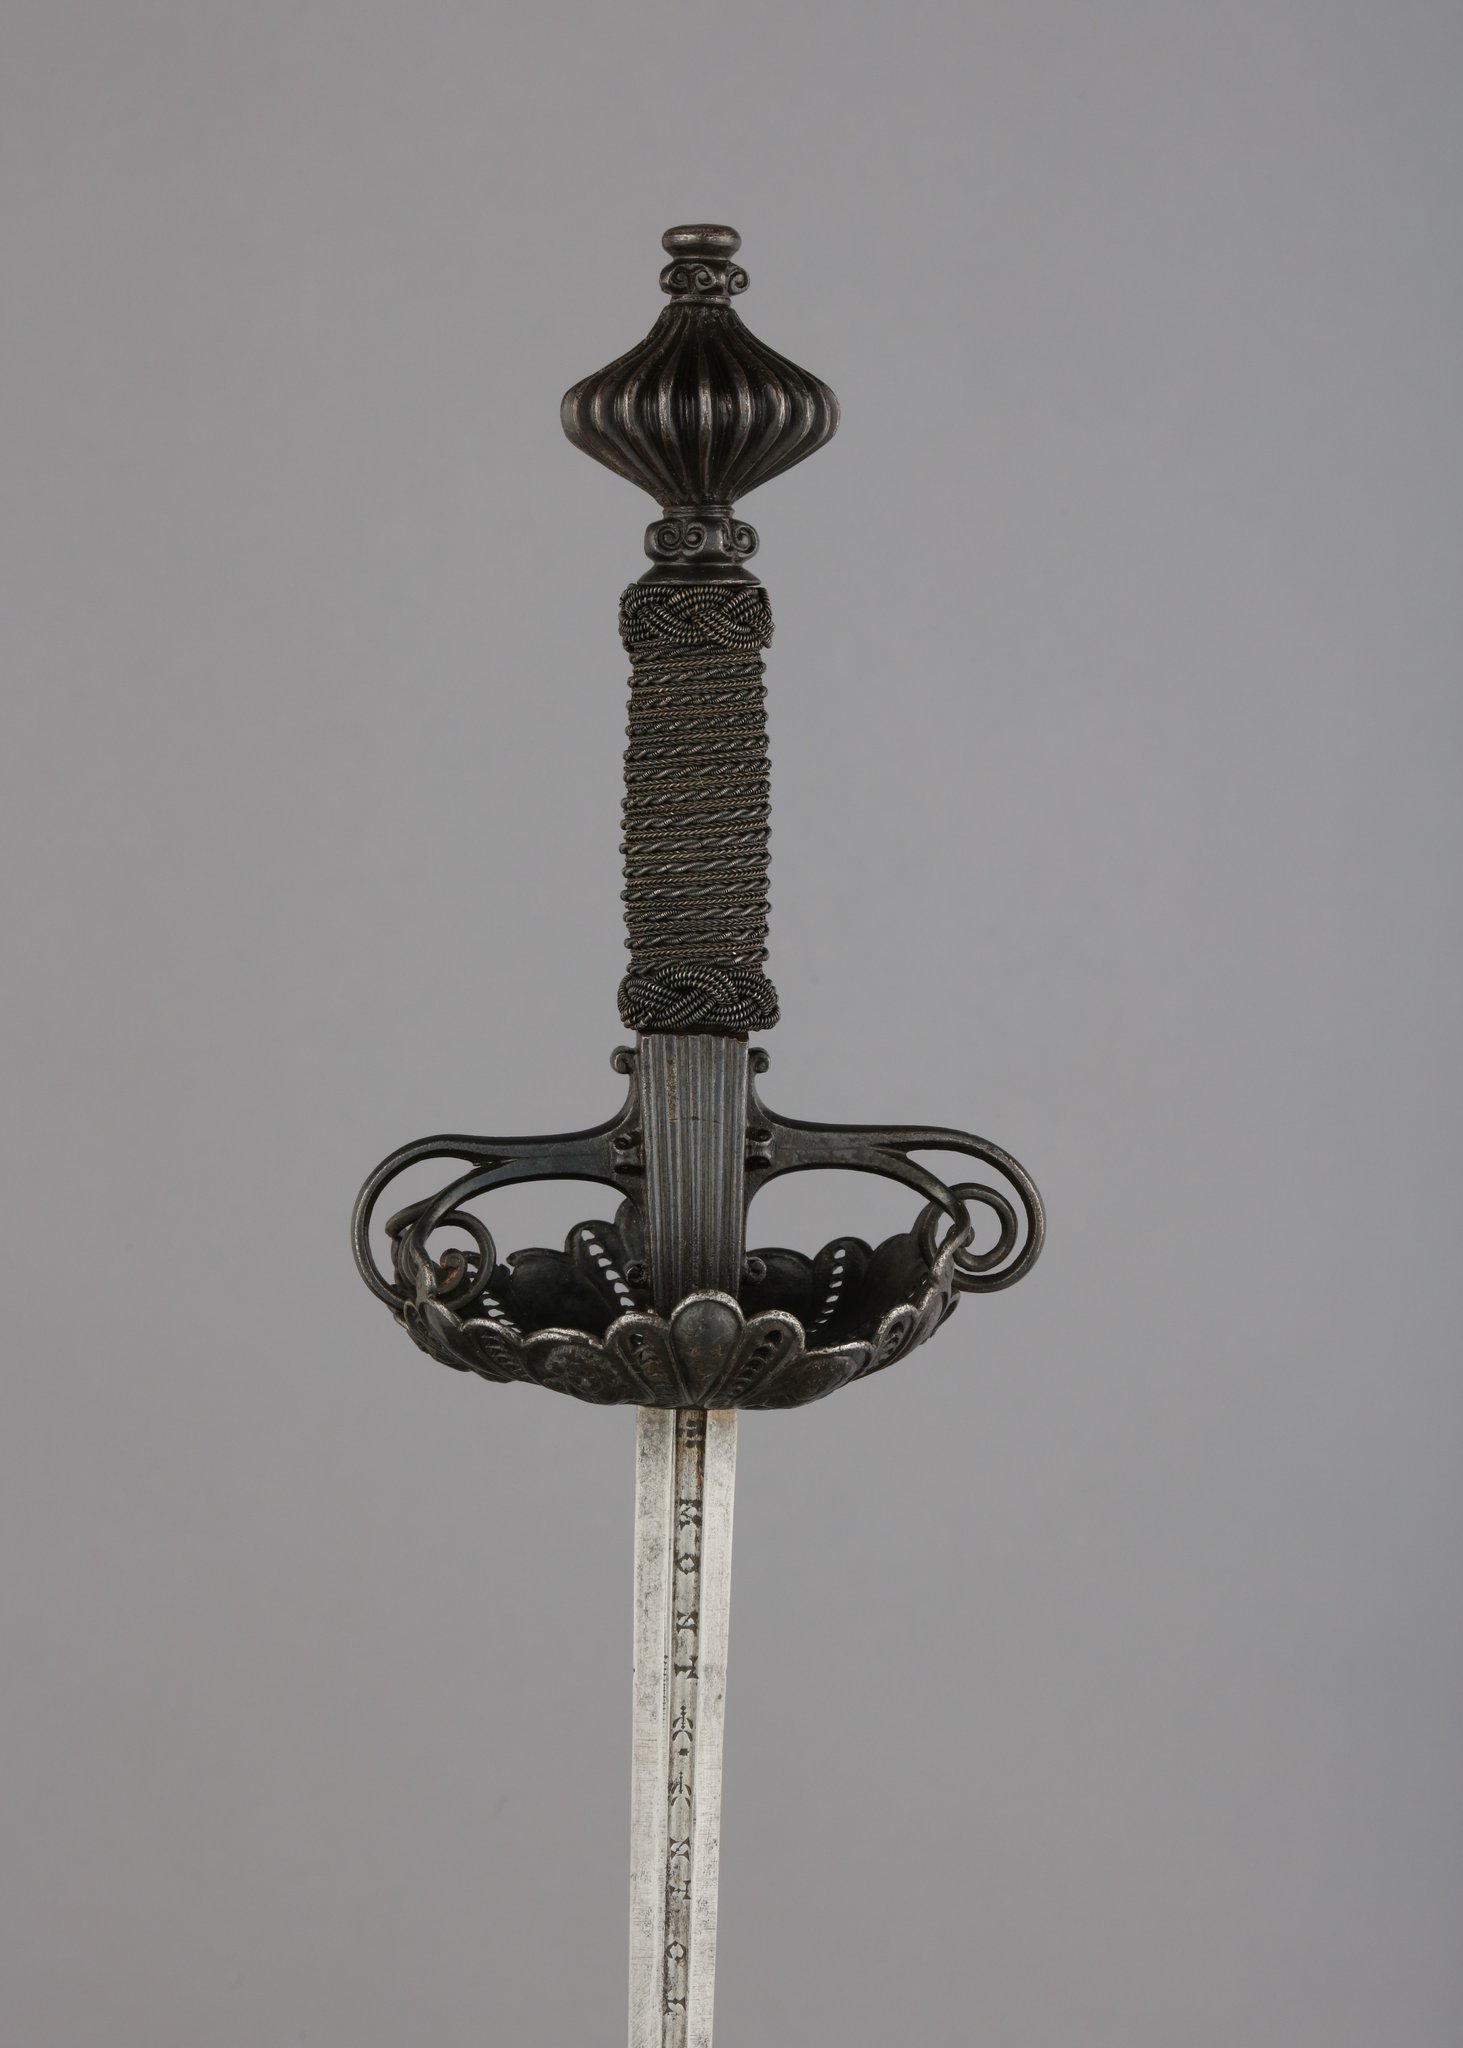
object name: rapier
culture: hilt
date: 1630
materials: iron, steel, wood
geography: netherlands